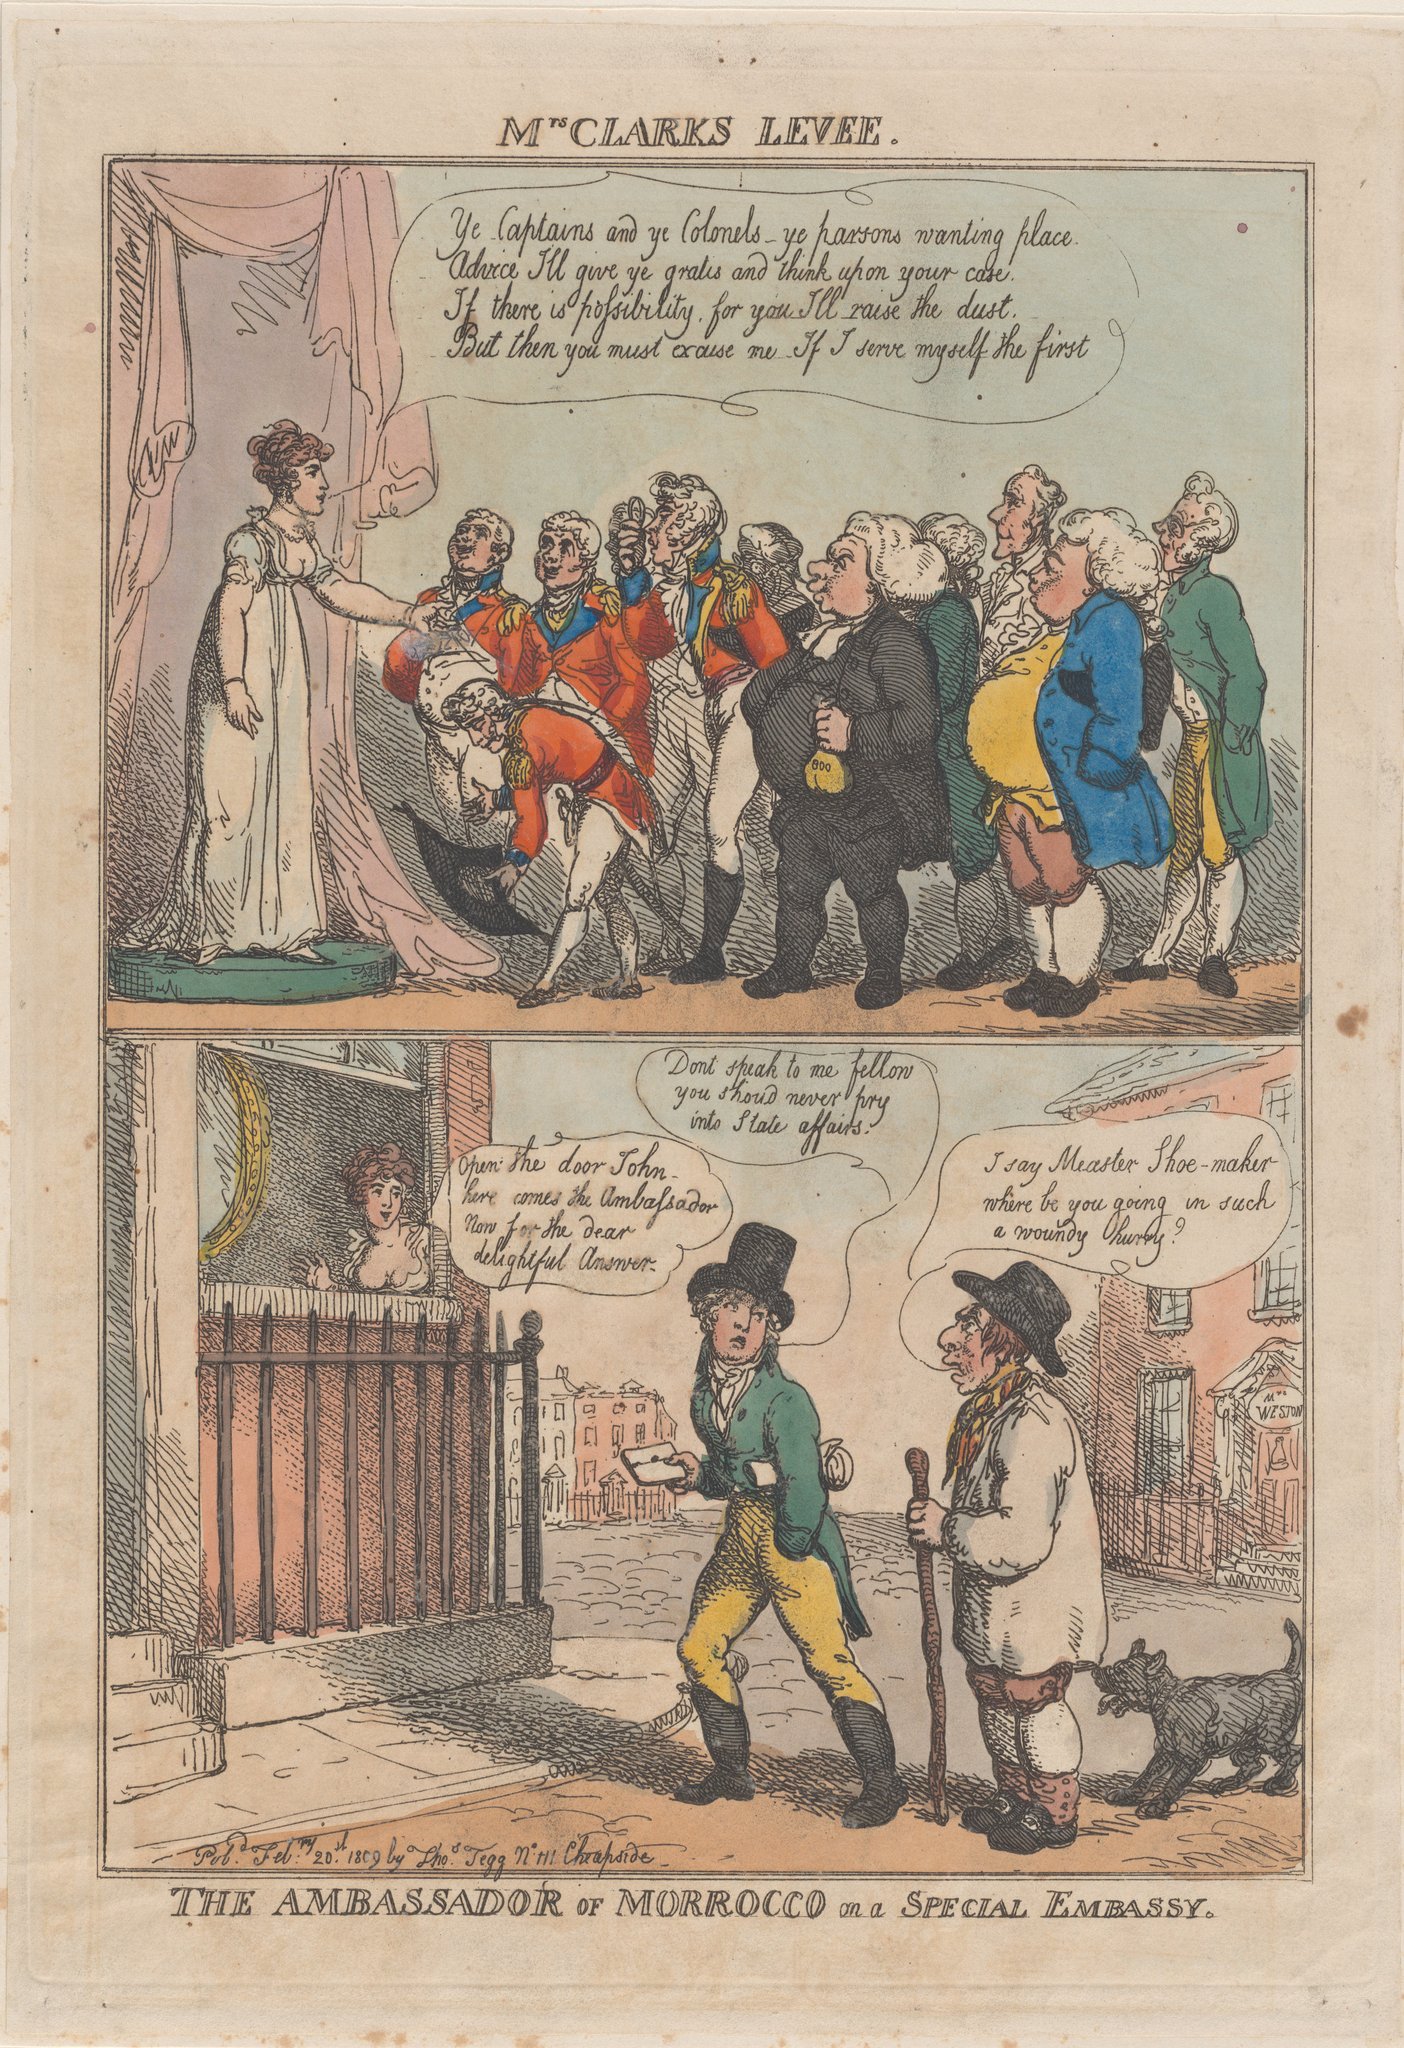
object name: print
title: The Ambassador of Morrocco on a Special Embassy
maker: thomas rowlandson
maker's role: artist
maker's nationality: british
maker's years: 1757-1827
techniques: etching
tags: satire,men,women,politics